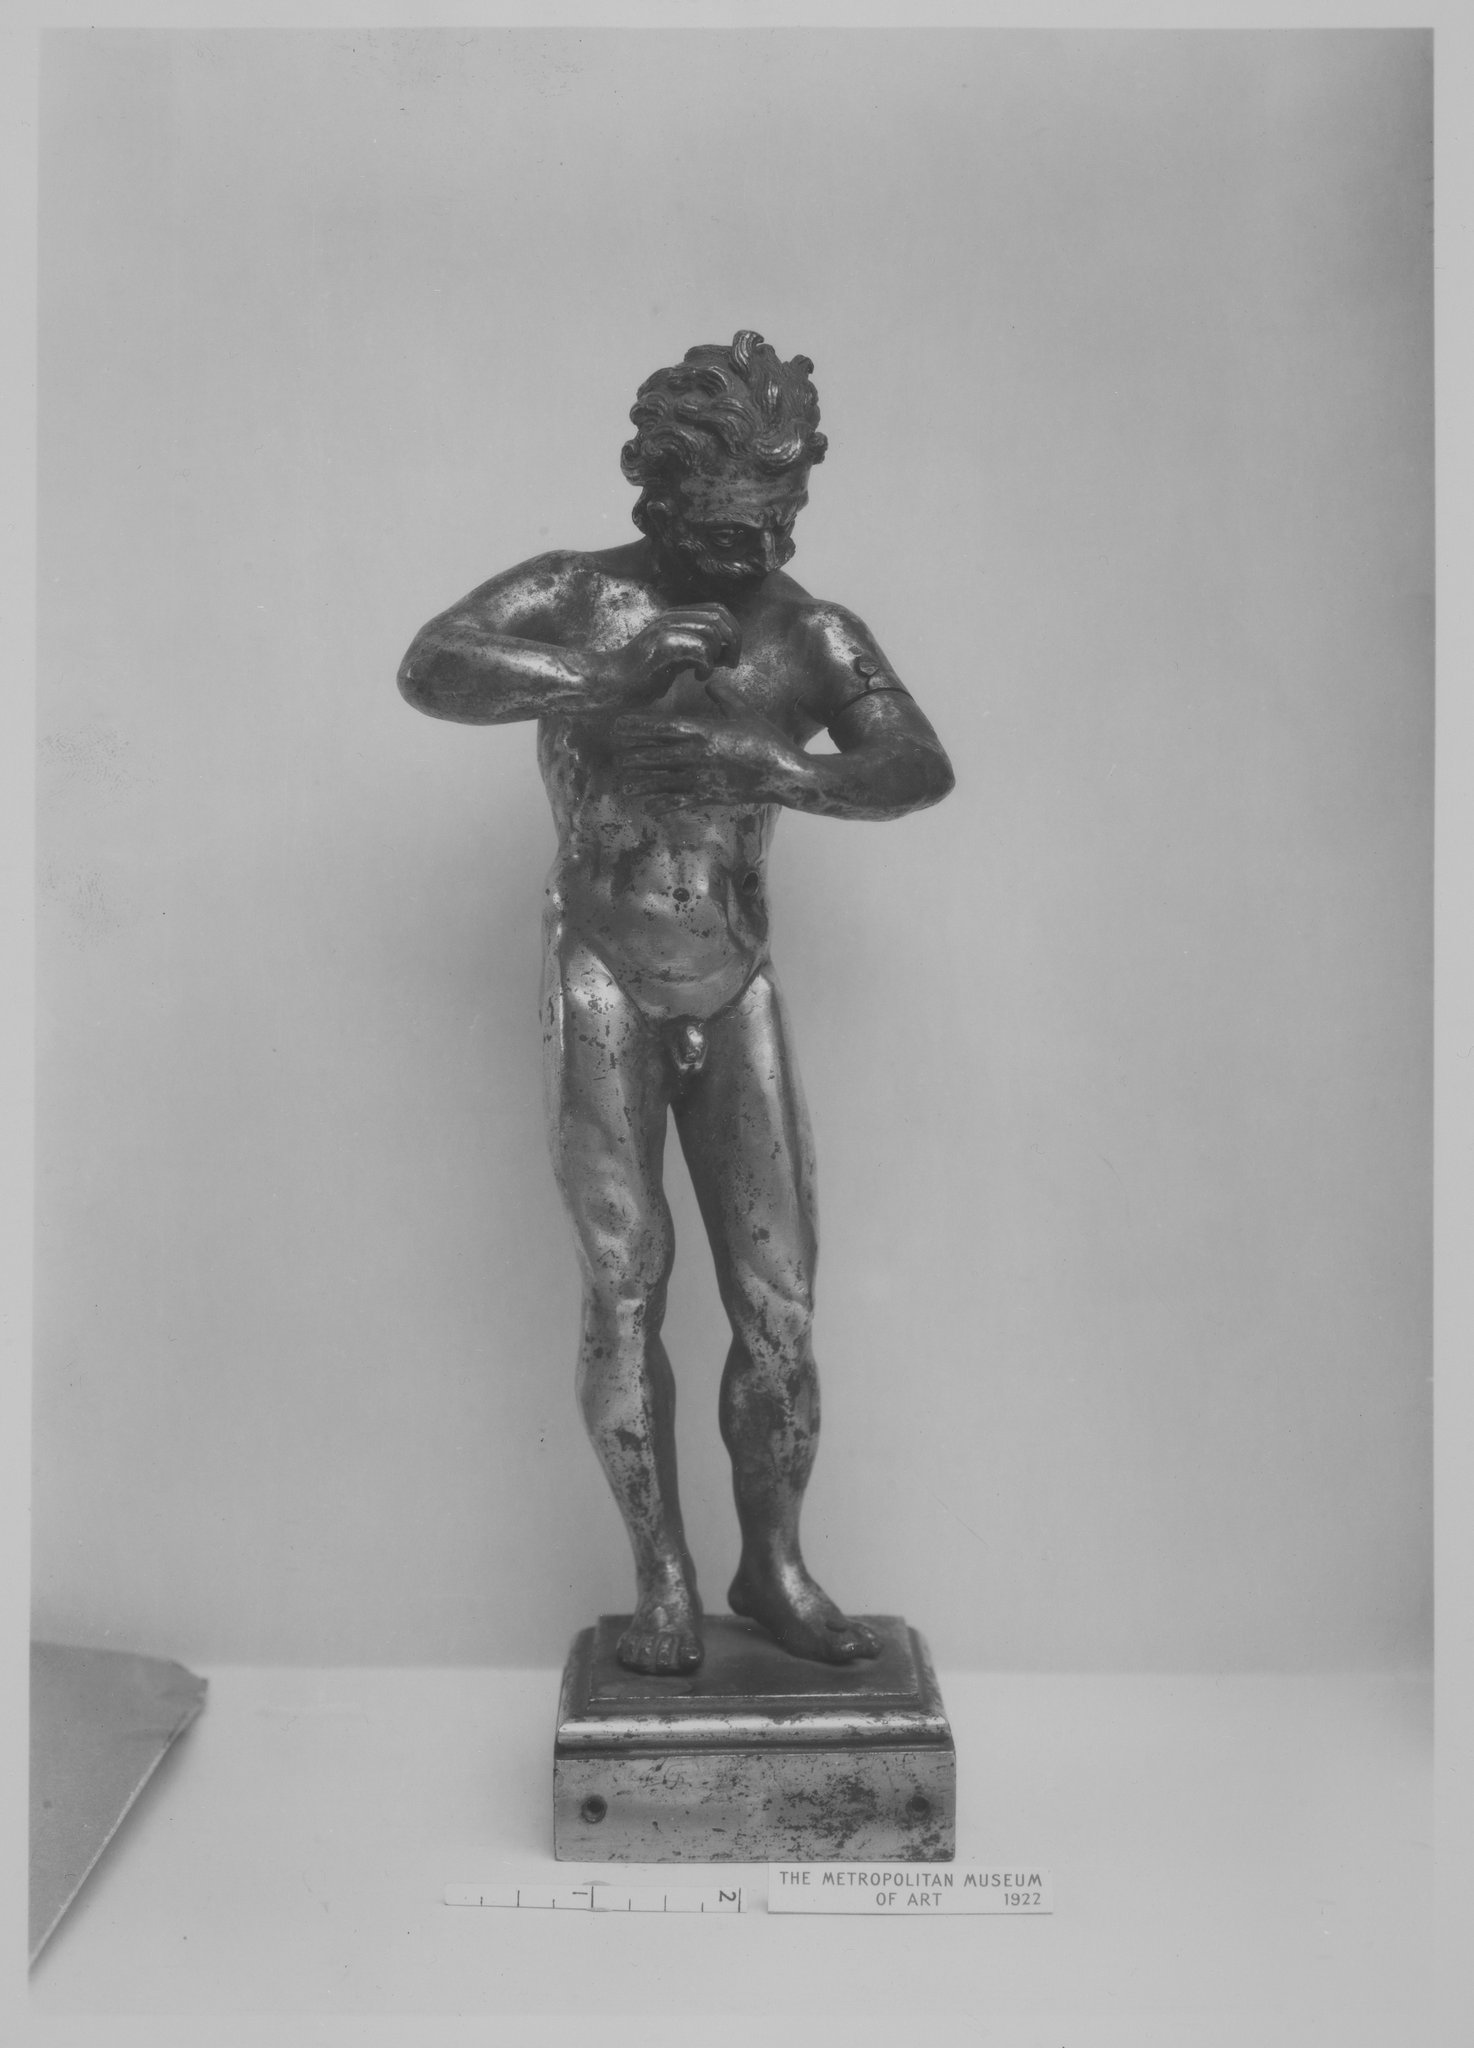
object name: statuette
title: Marsyas Playing the (missing) Double Flute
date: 1567-1600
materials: gilt bronze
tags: male nudes